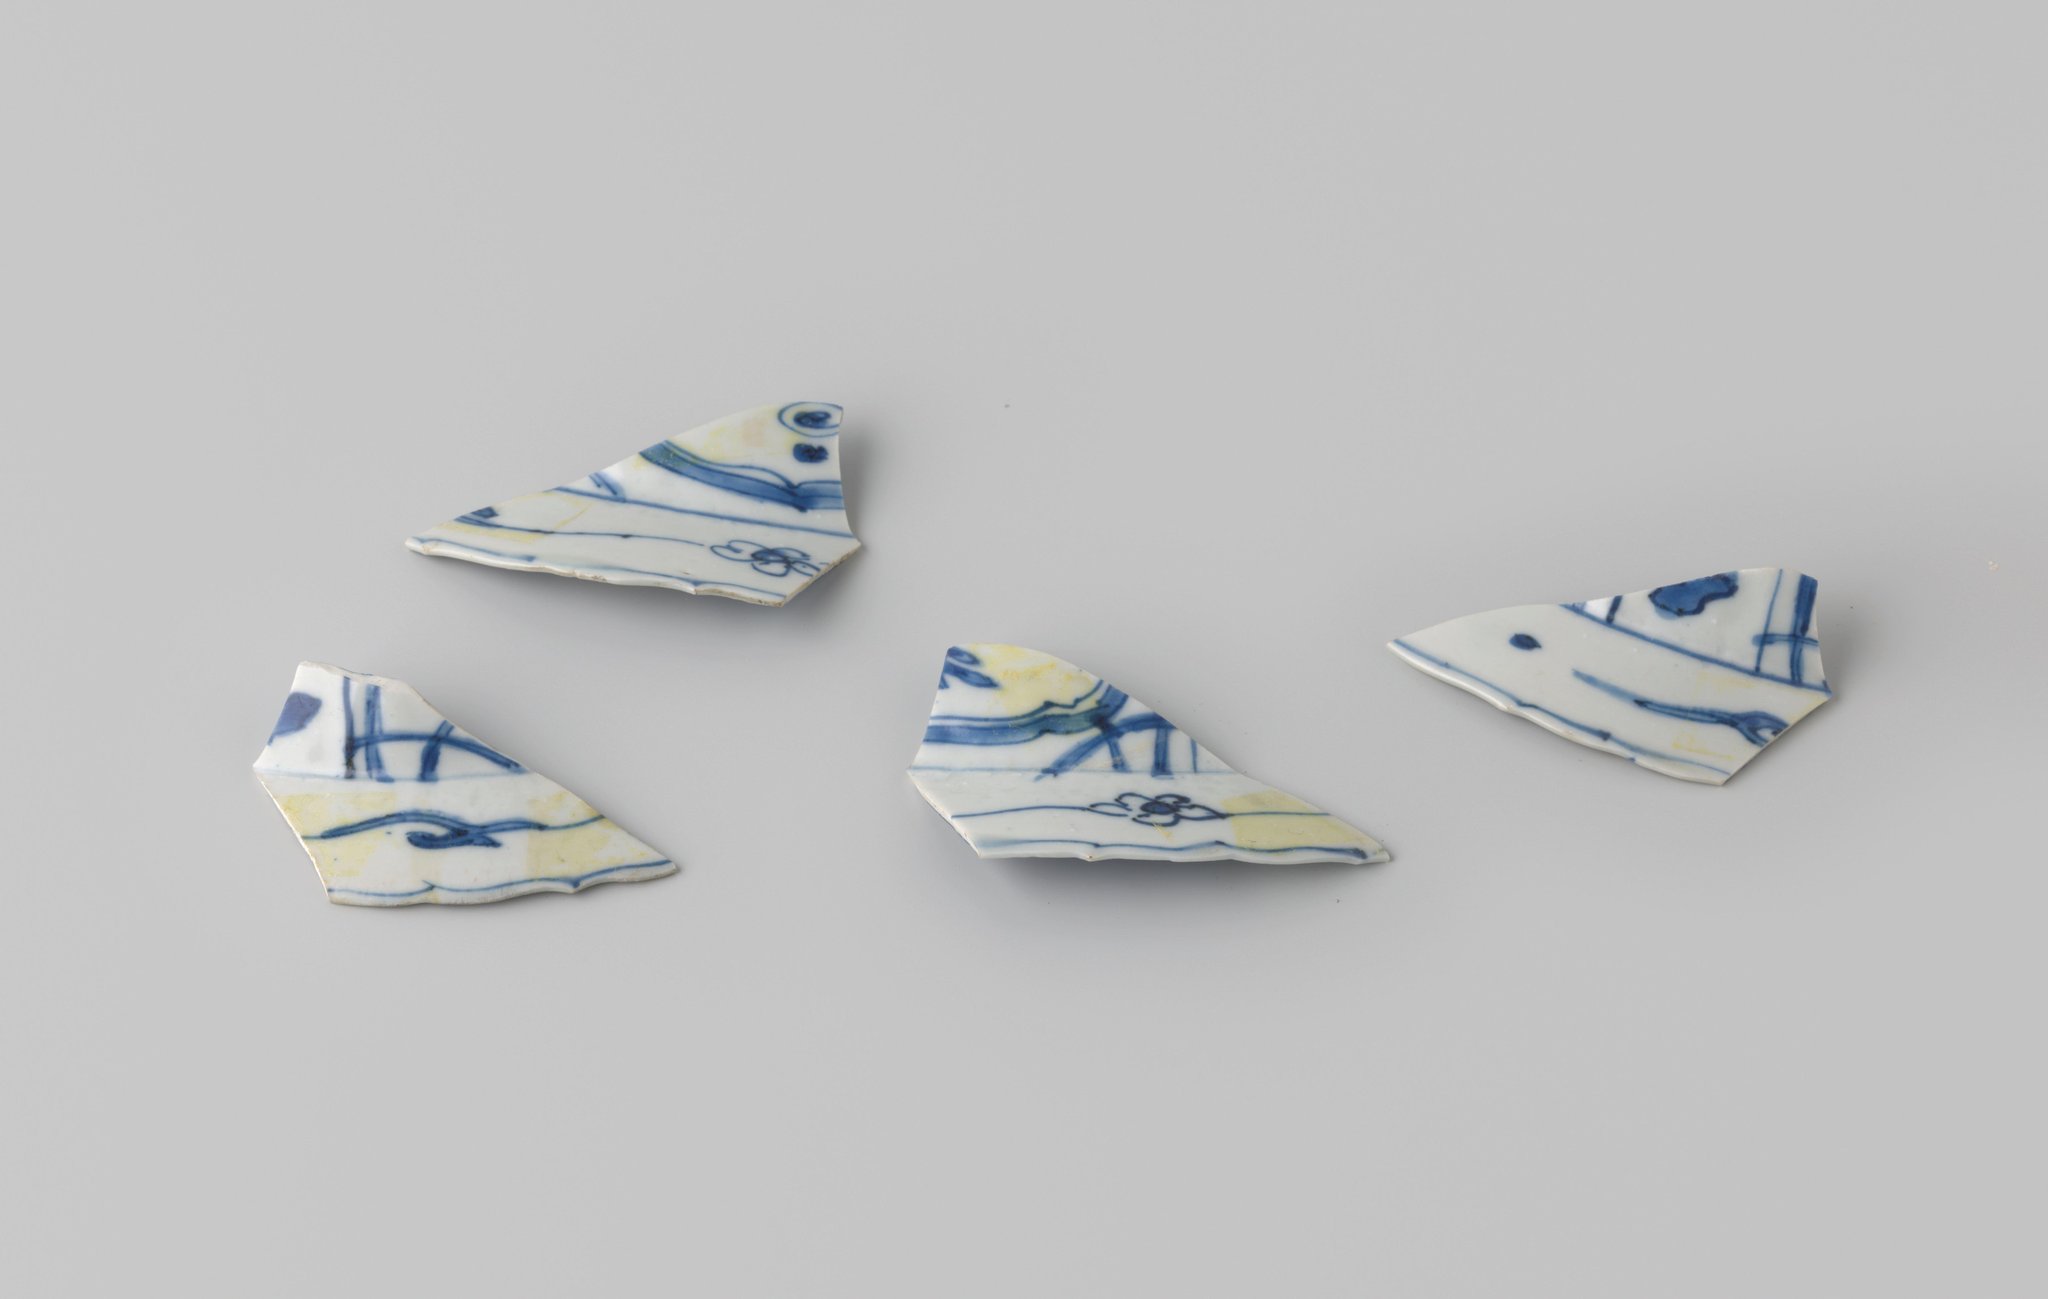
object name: sherd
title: Scherven van een diep bord uit V.O.C.-schip de 'Witte Leeuw'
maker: Anonymous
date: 1613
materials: bone china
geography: jingdezhen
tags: plants and herbs: peony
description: A bowl with a flattened rim. Cartouches with fruits enclosed by diaper patterns. A central decoration of bird on a rock and a peony. Panels decorated with peaches and symbols.